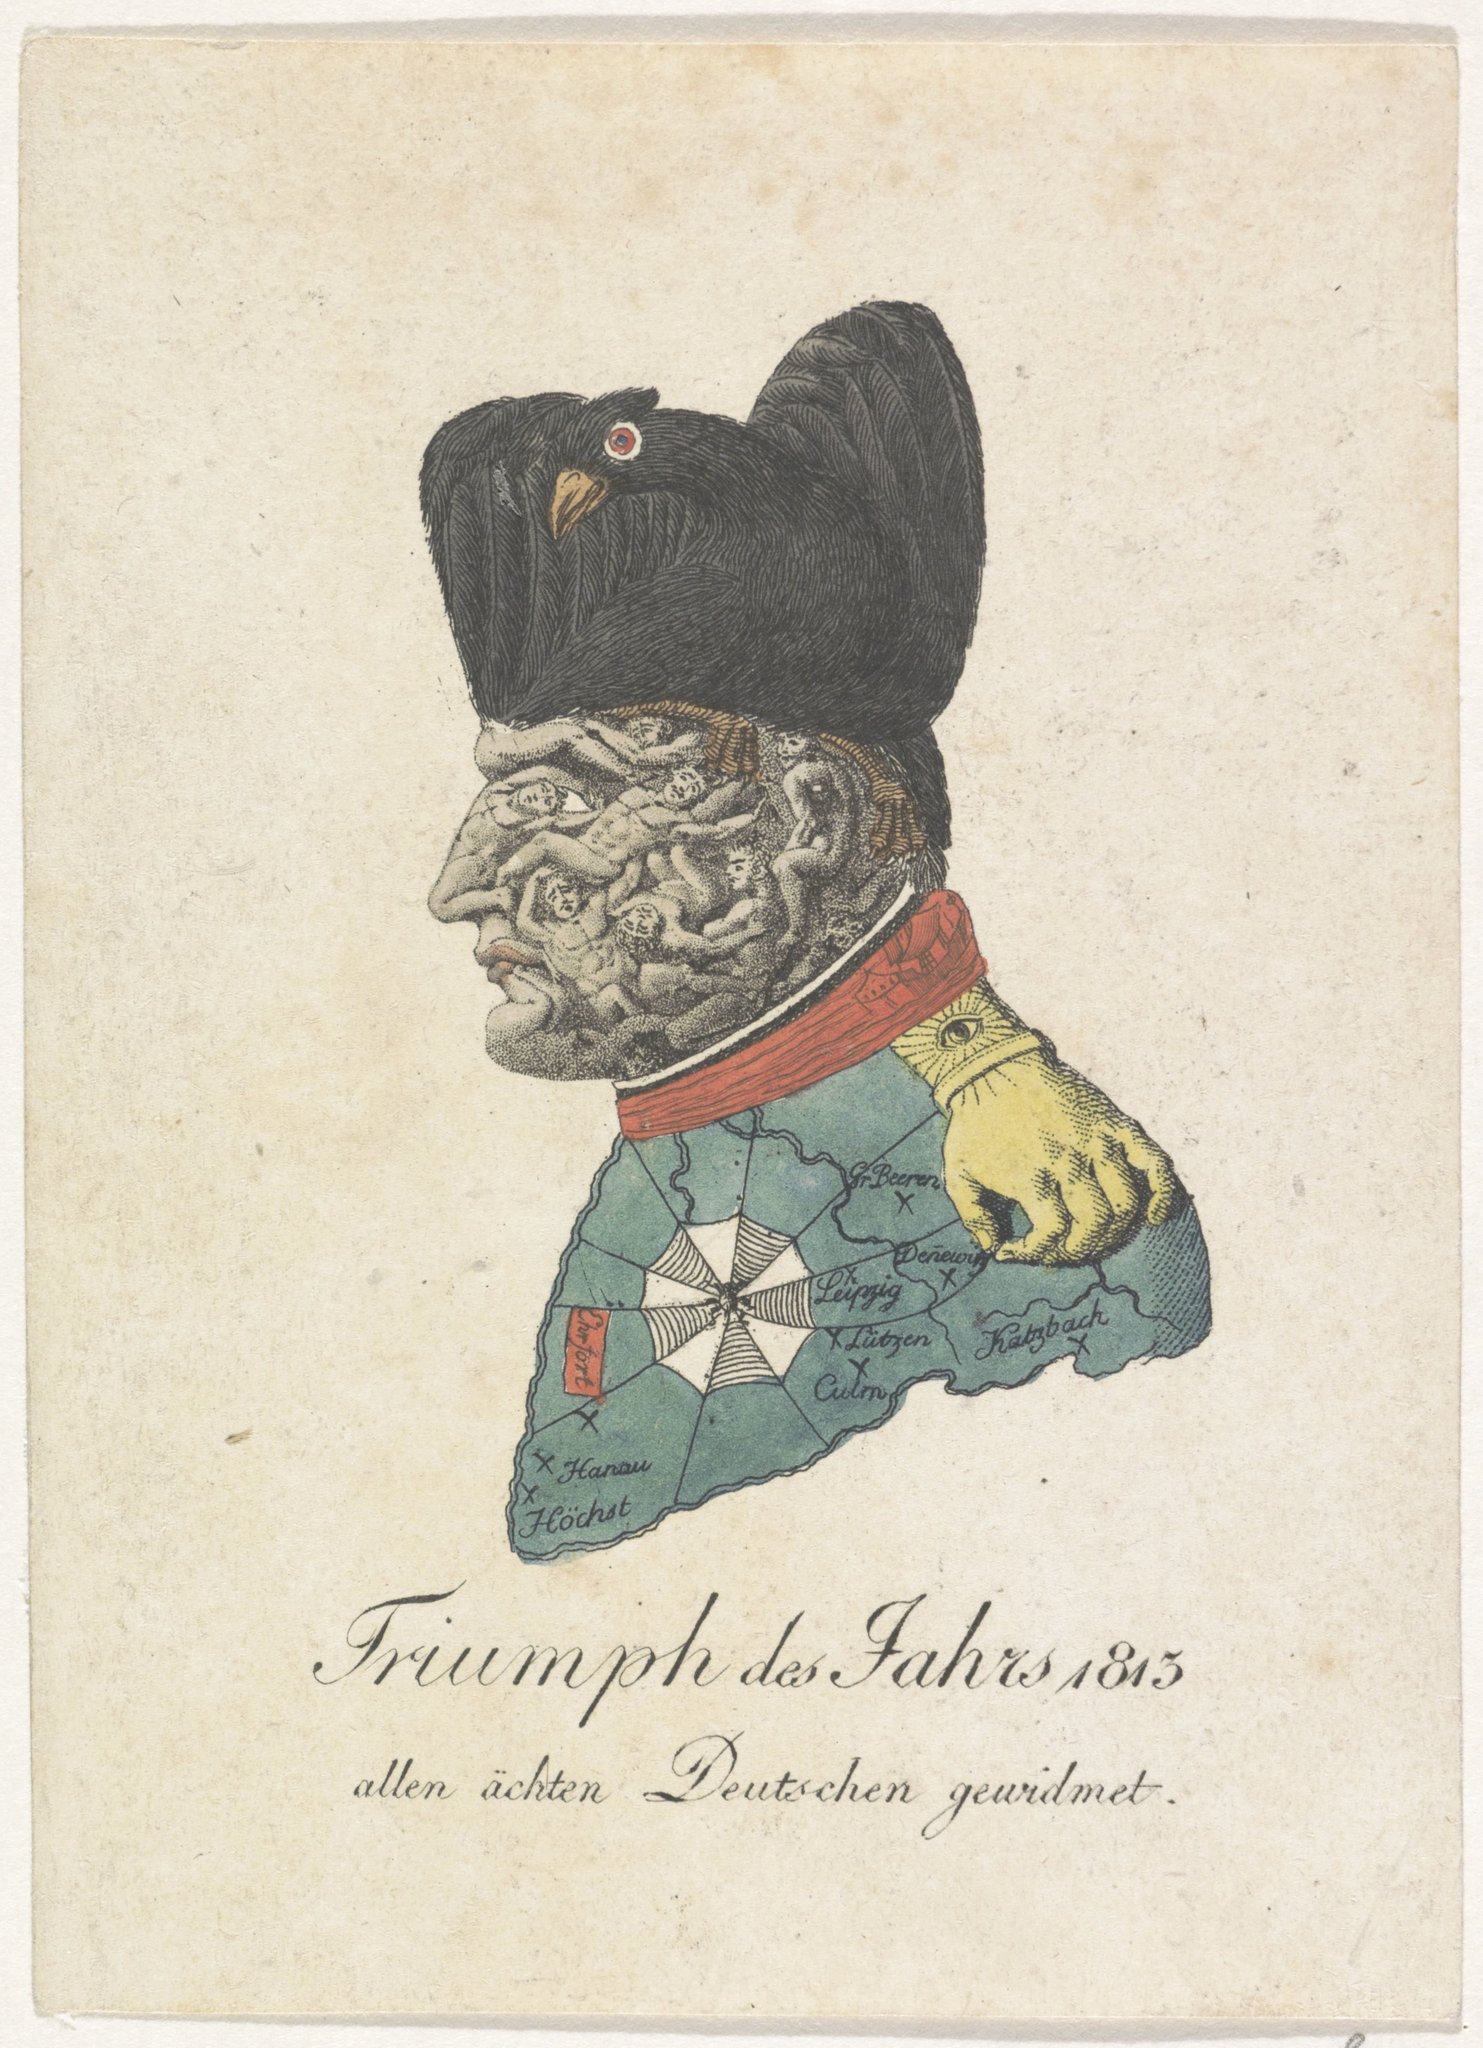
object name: cartoon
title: Triumph des Jahrs 1813 / allen ächten Deutschen gewidmet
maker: Anonymous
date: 1813-1814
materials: paper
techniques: etching, hand coloring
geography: germany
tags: napoleon i (emperor of the french), political caricatures and satires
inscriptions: collector's mark: Lugt 2228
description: Spotprent op Napoleon van 1813 waarbij zijn gezicht is opgebouwd uit de lijken van zijn slachtoffers, zijn hoed is de Pruisische adelaar, zijn epaulet is een grijpende hand. De kraag is een rivier van bloed, zijn jas het slagveld van Europa en het ordeteken van het Legioen van Eer op zijn borst is een spinnenweb.